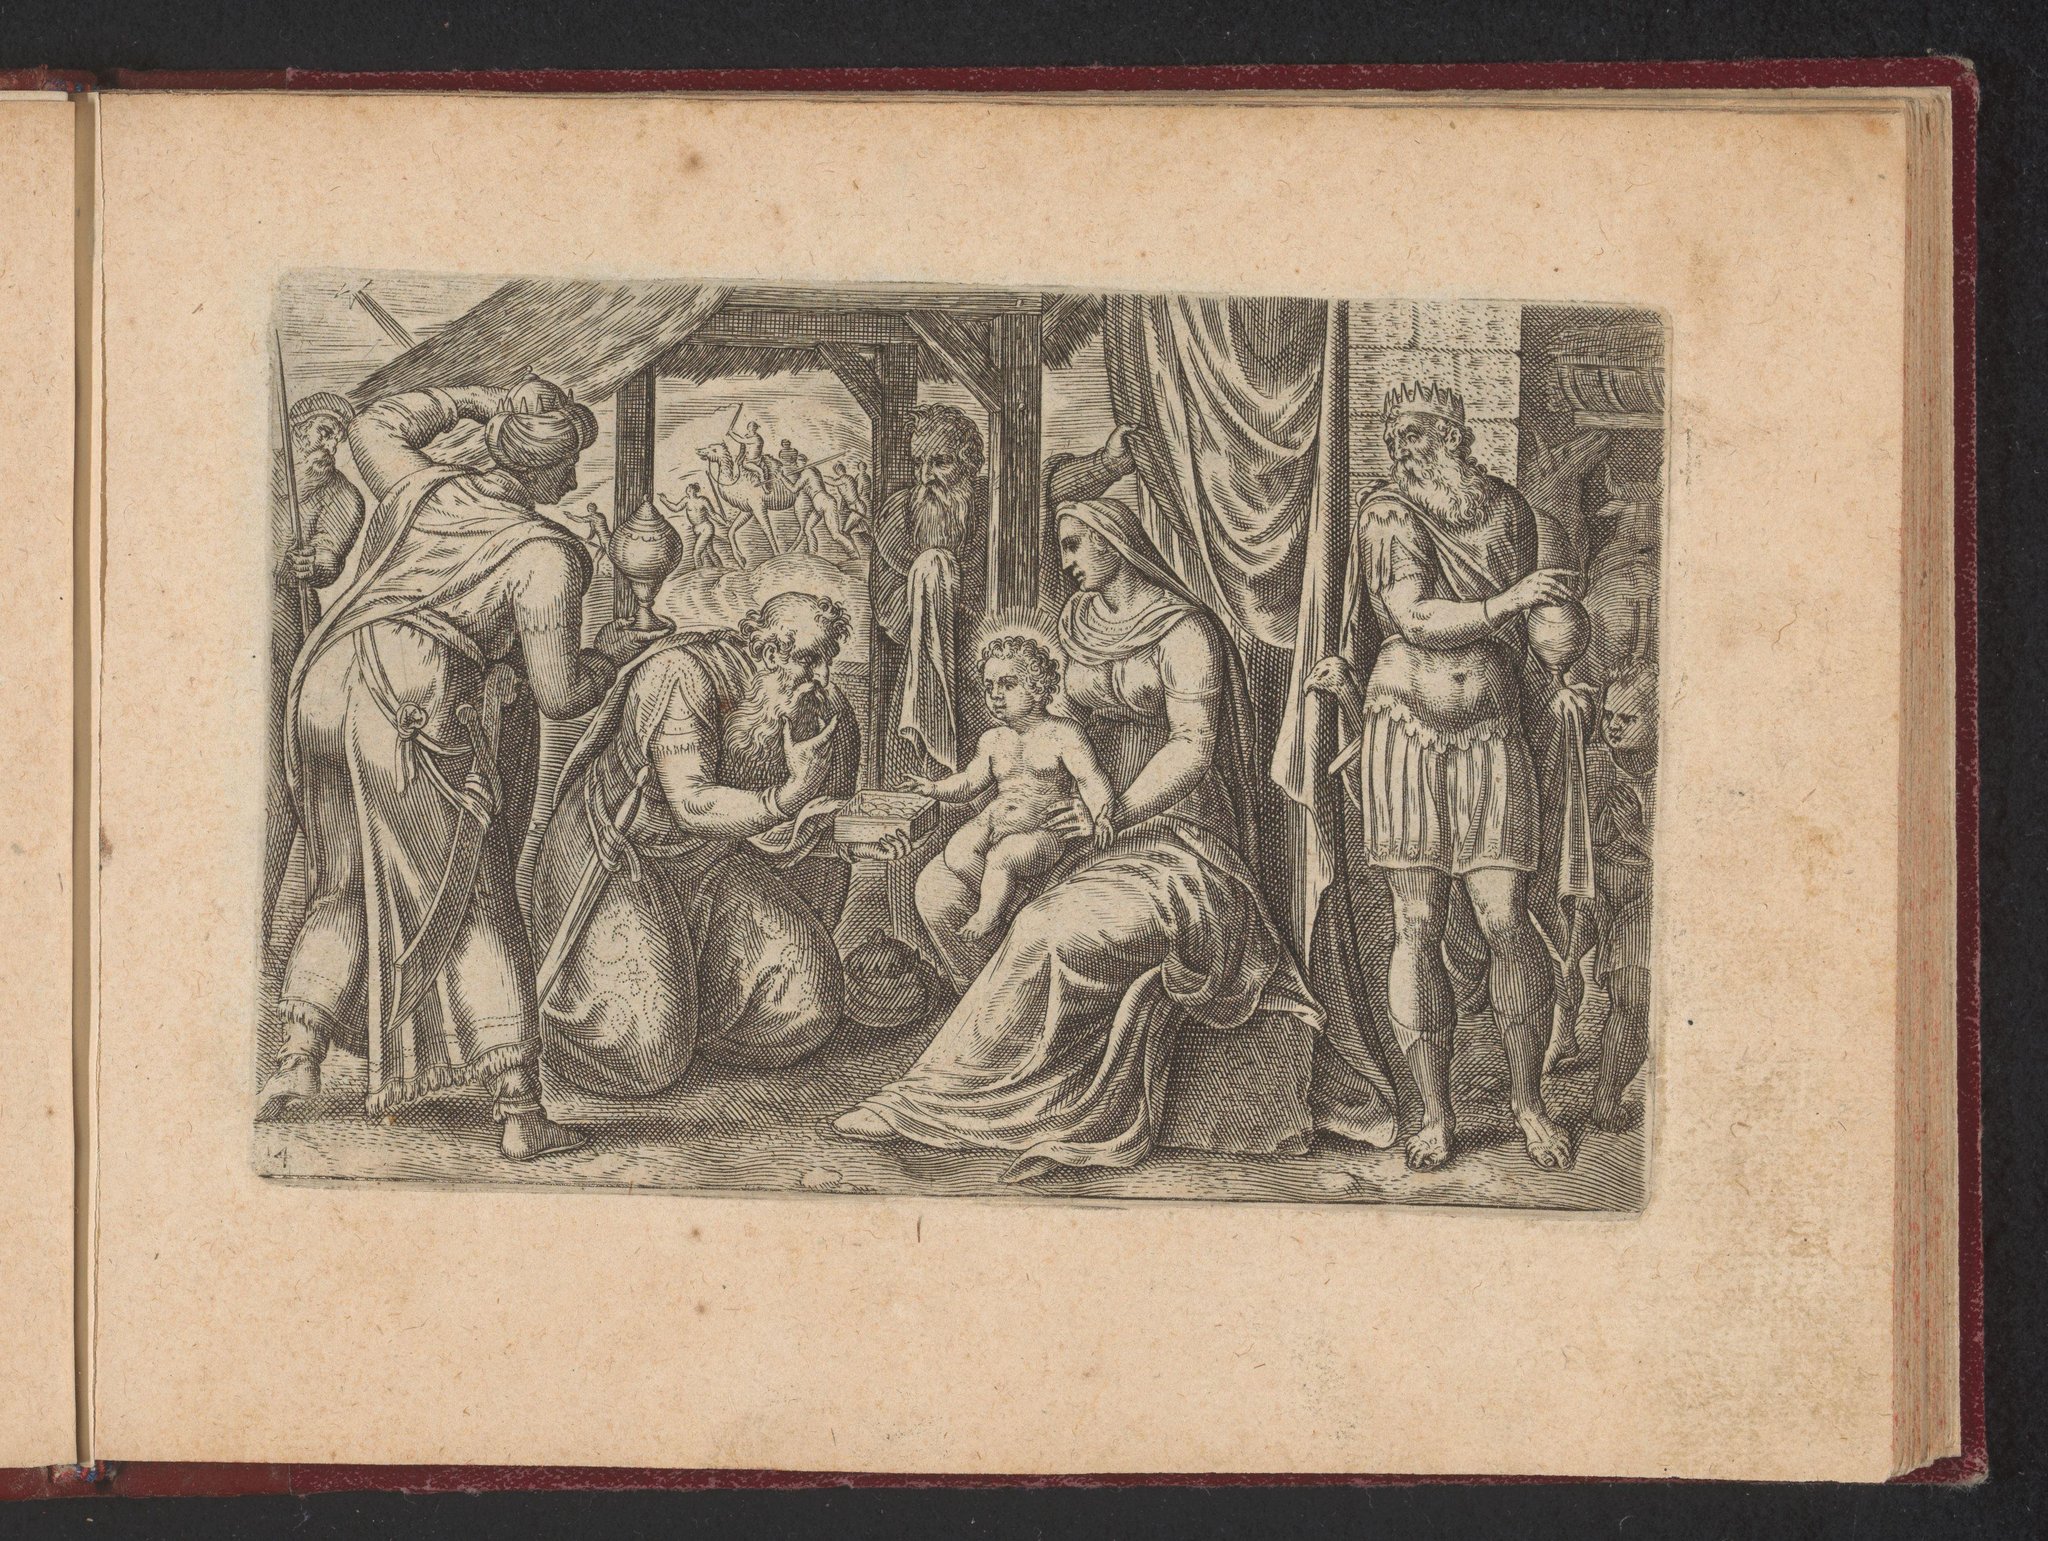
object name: print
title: Christi Iesu vitae admirabiliumque actionum speculum a Philippo Gallaeo apparatum Bened. Ariae Montani singuloribus distichis instructum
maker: philips galle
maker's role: print maker, publisher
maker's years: 1537-1612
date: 1573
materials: paper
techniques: engraving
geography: antwerp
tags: adoration of the kings: the wise men present their gifts to the christ-child (gold, frankincense and myrrh)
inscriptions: watermark: ‘gotische letter P’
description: Onderdeel van een album met een titelprent en een serie van 50 prenten betreffende het leven en de passie van Christus.